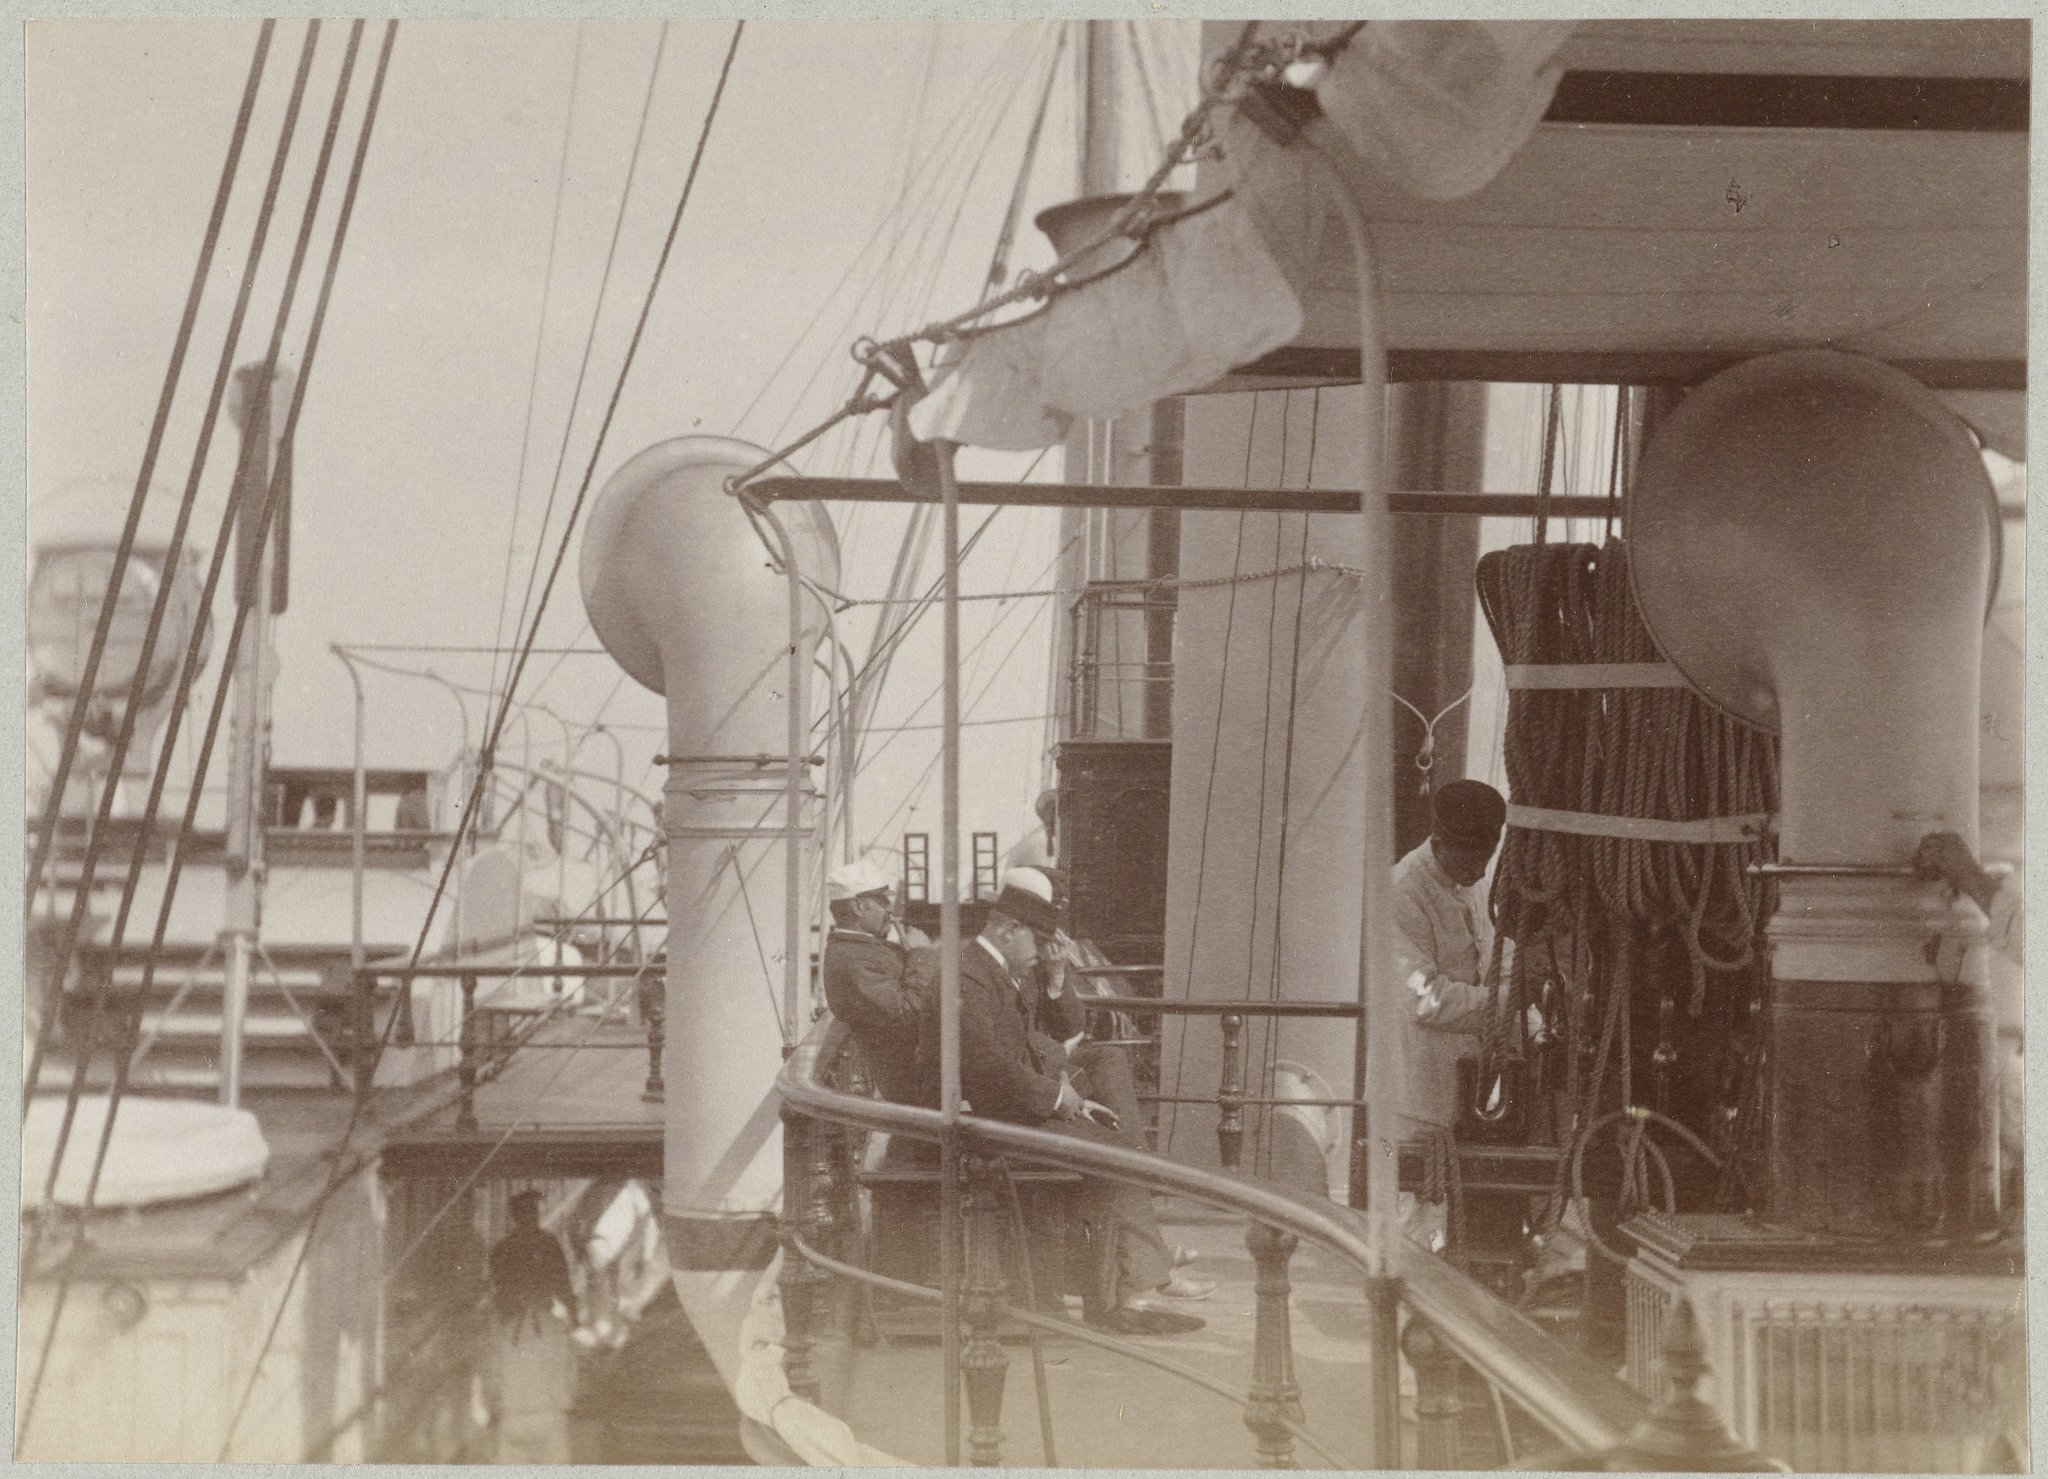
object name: photograph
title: Passagiers en personeel op het bovendek van schip op de Noorse zee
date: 1807-1889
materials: cardboard, paper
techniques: albumen print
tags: wilhelm ii (keizer van duitsland), norway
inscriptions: number: ‘28’